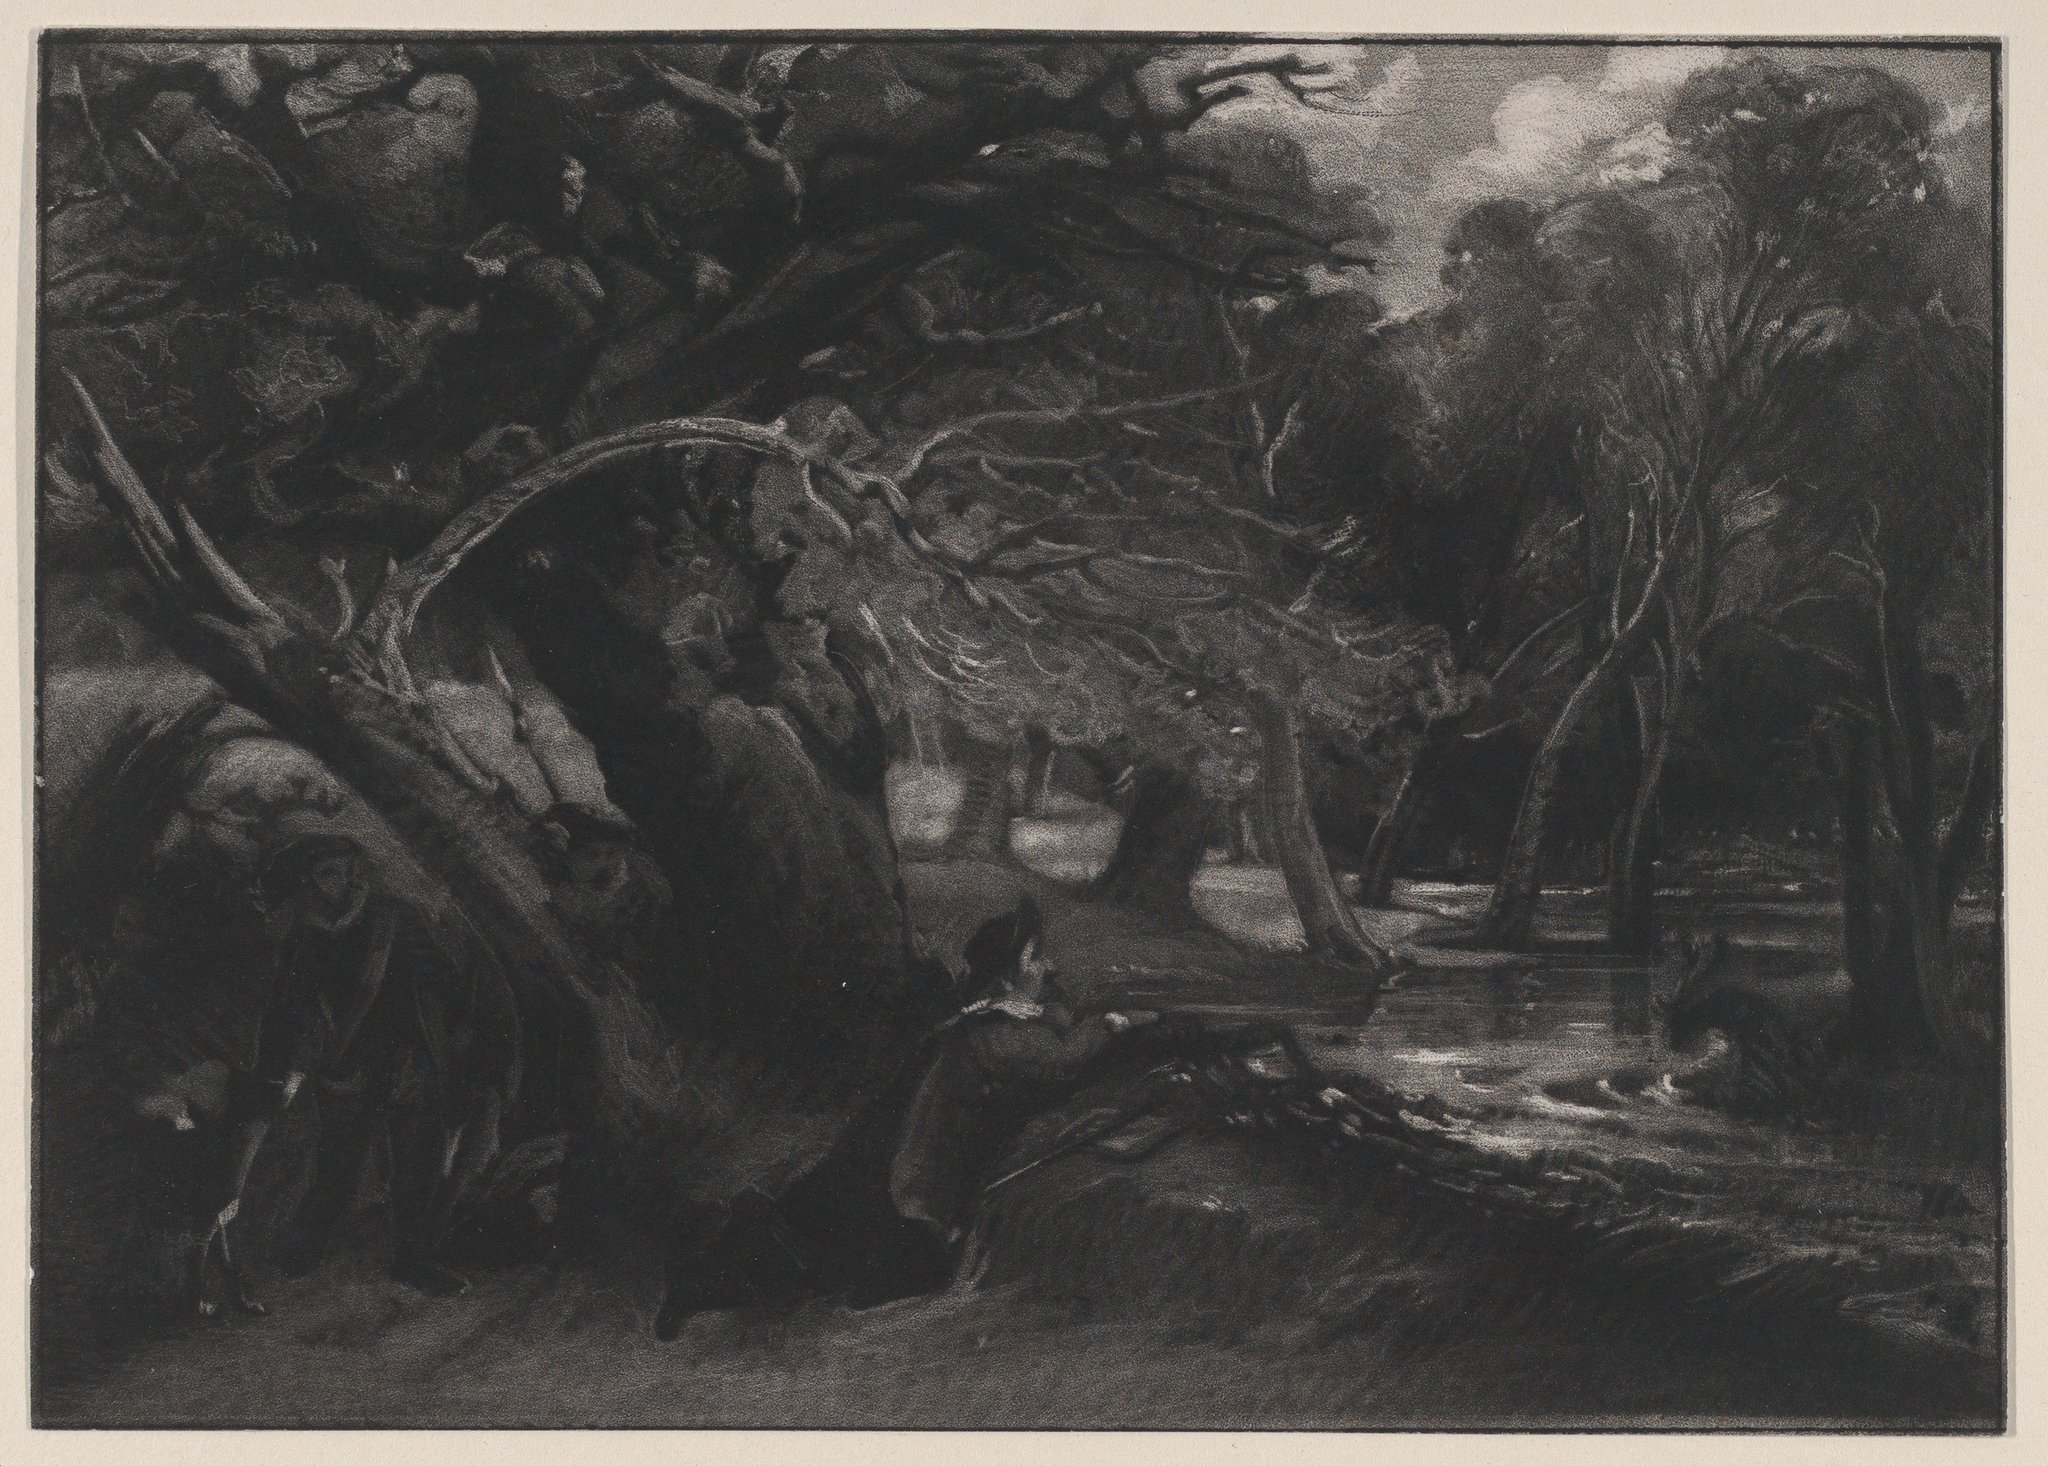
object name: print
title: Jacques and the Wounded Stag (Shakespeare, As You Like It, Act 2, Scene 1)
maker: david lucas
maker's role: engraver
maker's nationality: british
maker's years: 1802-1881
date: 1830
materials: chalk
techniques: mezzotint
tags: shakespeare,men,hunting,deer,forests